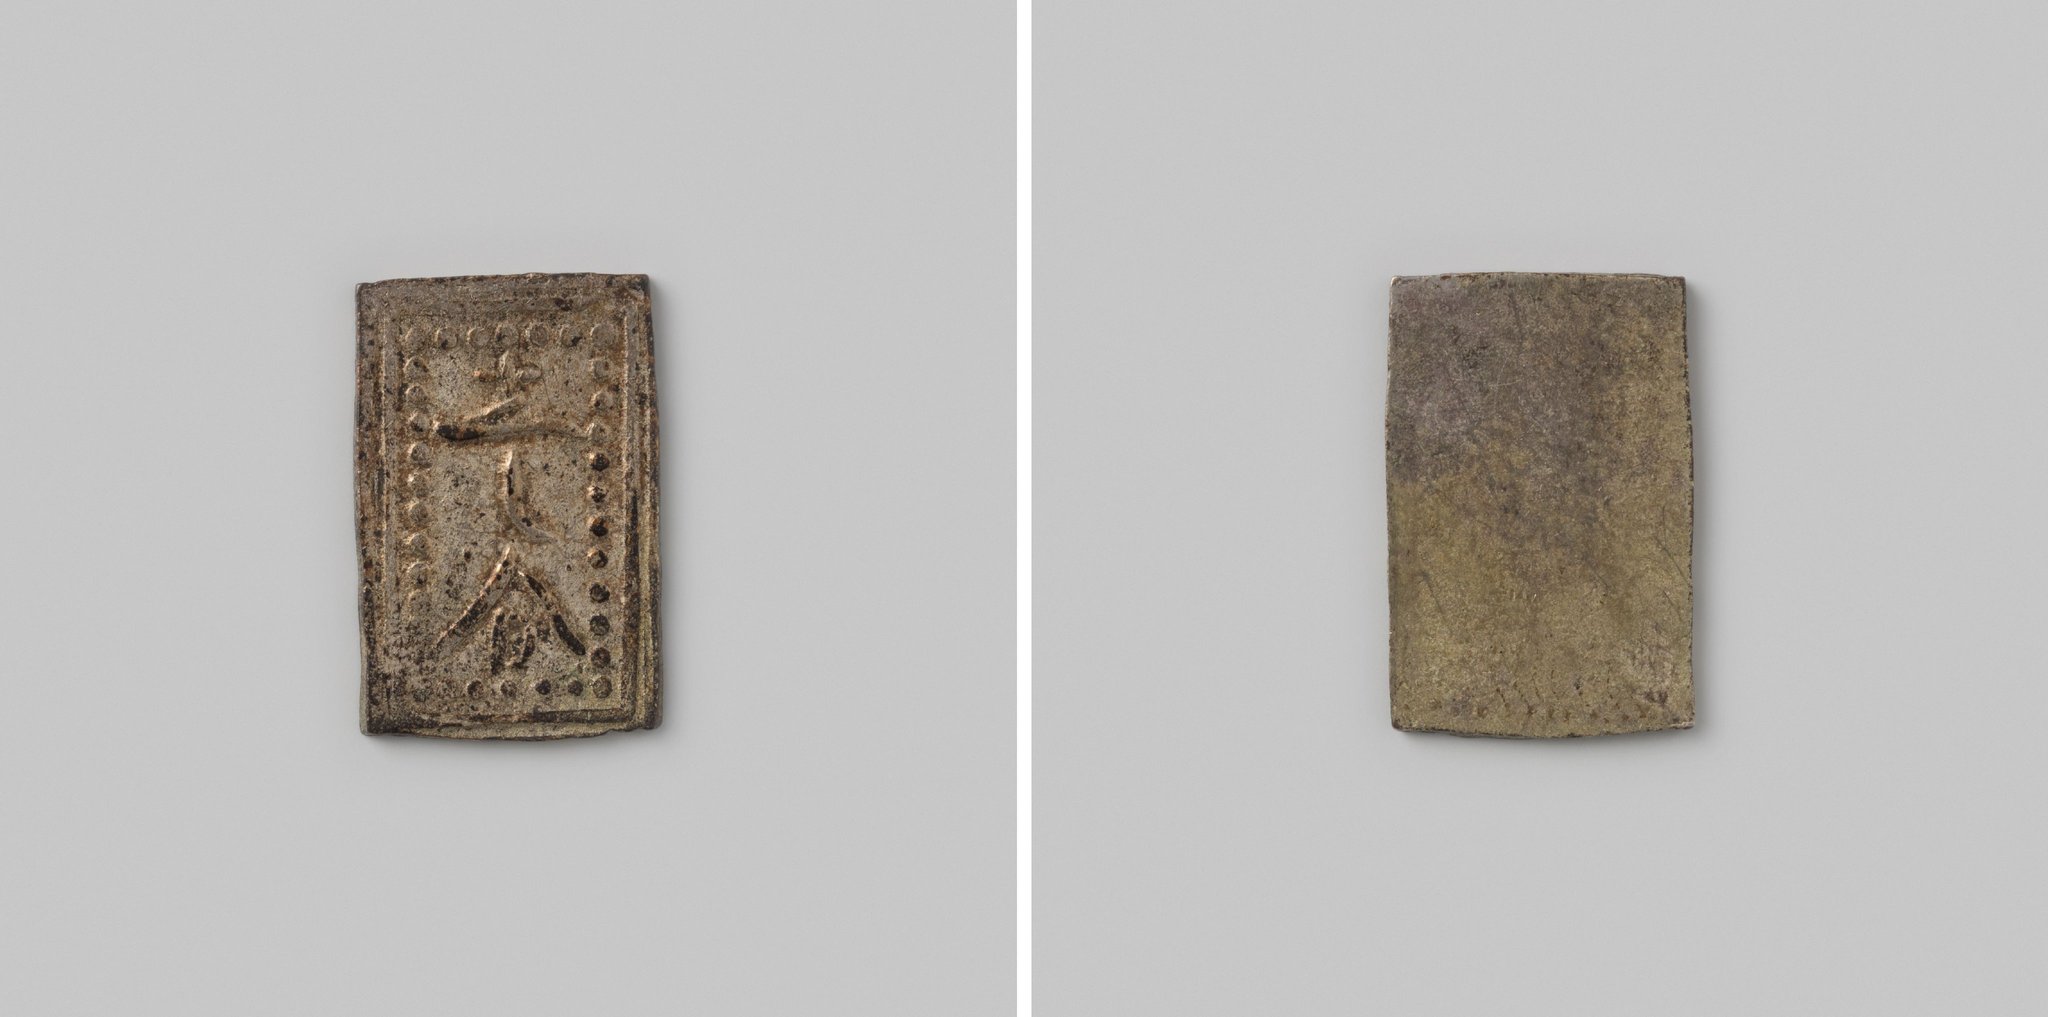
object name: coin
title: Nan rio gin uit het keizerrijk Japan van keizer Gomomo zono met de regeringsnaam An-jeï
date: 1772-1780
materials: silver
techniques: striking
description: Zilveren rechthoekige munt. Voorzijde: binnen rechthoek drie onder elkaar geplaatste tekens. Boven rechthoek versiering. Keerzijde: glad.